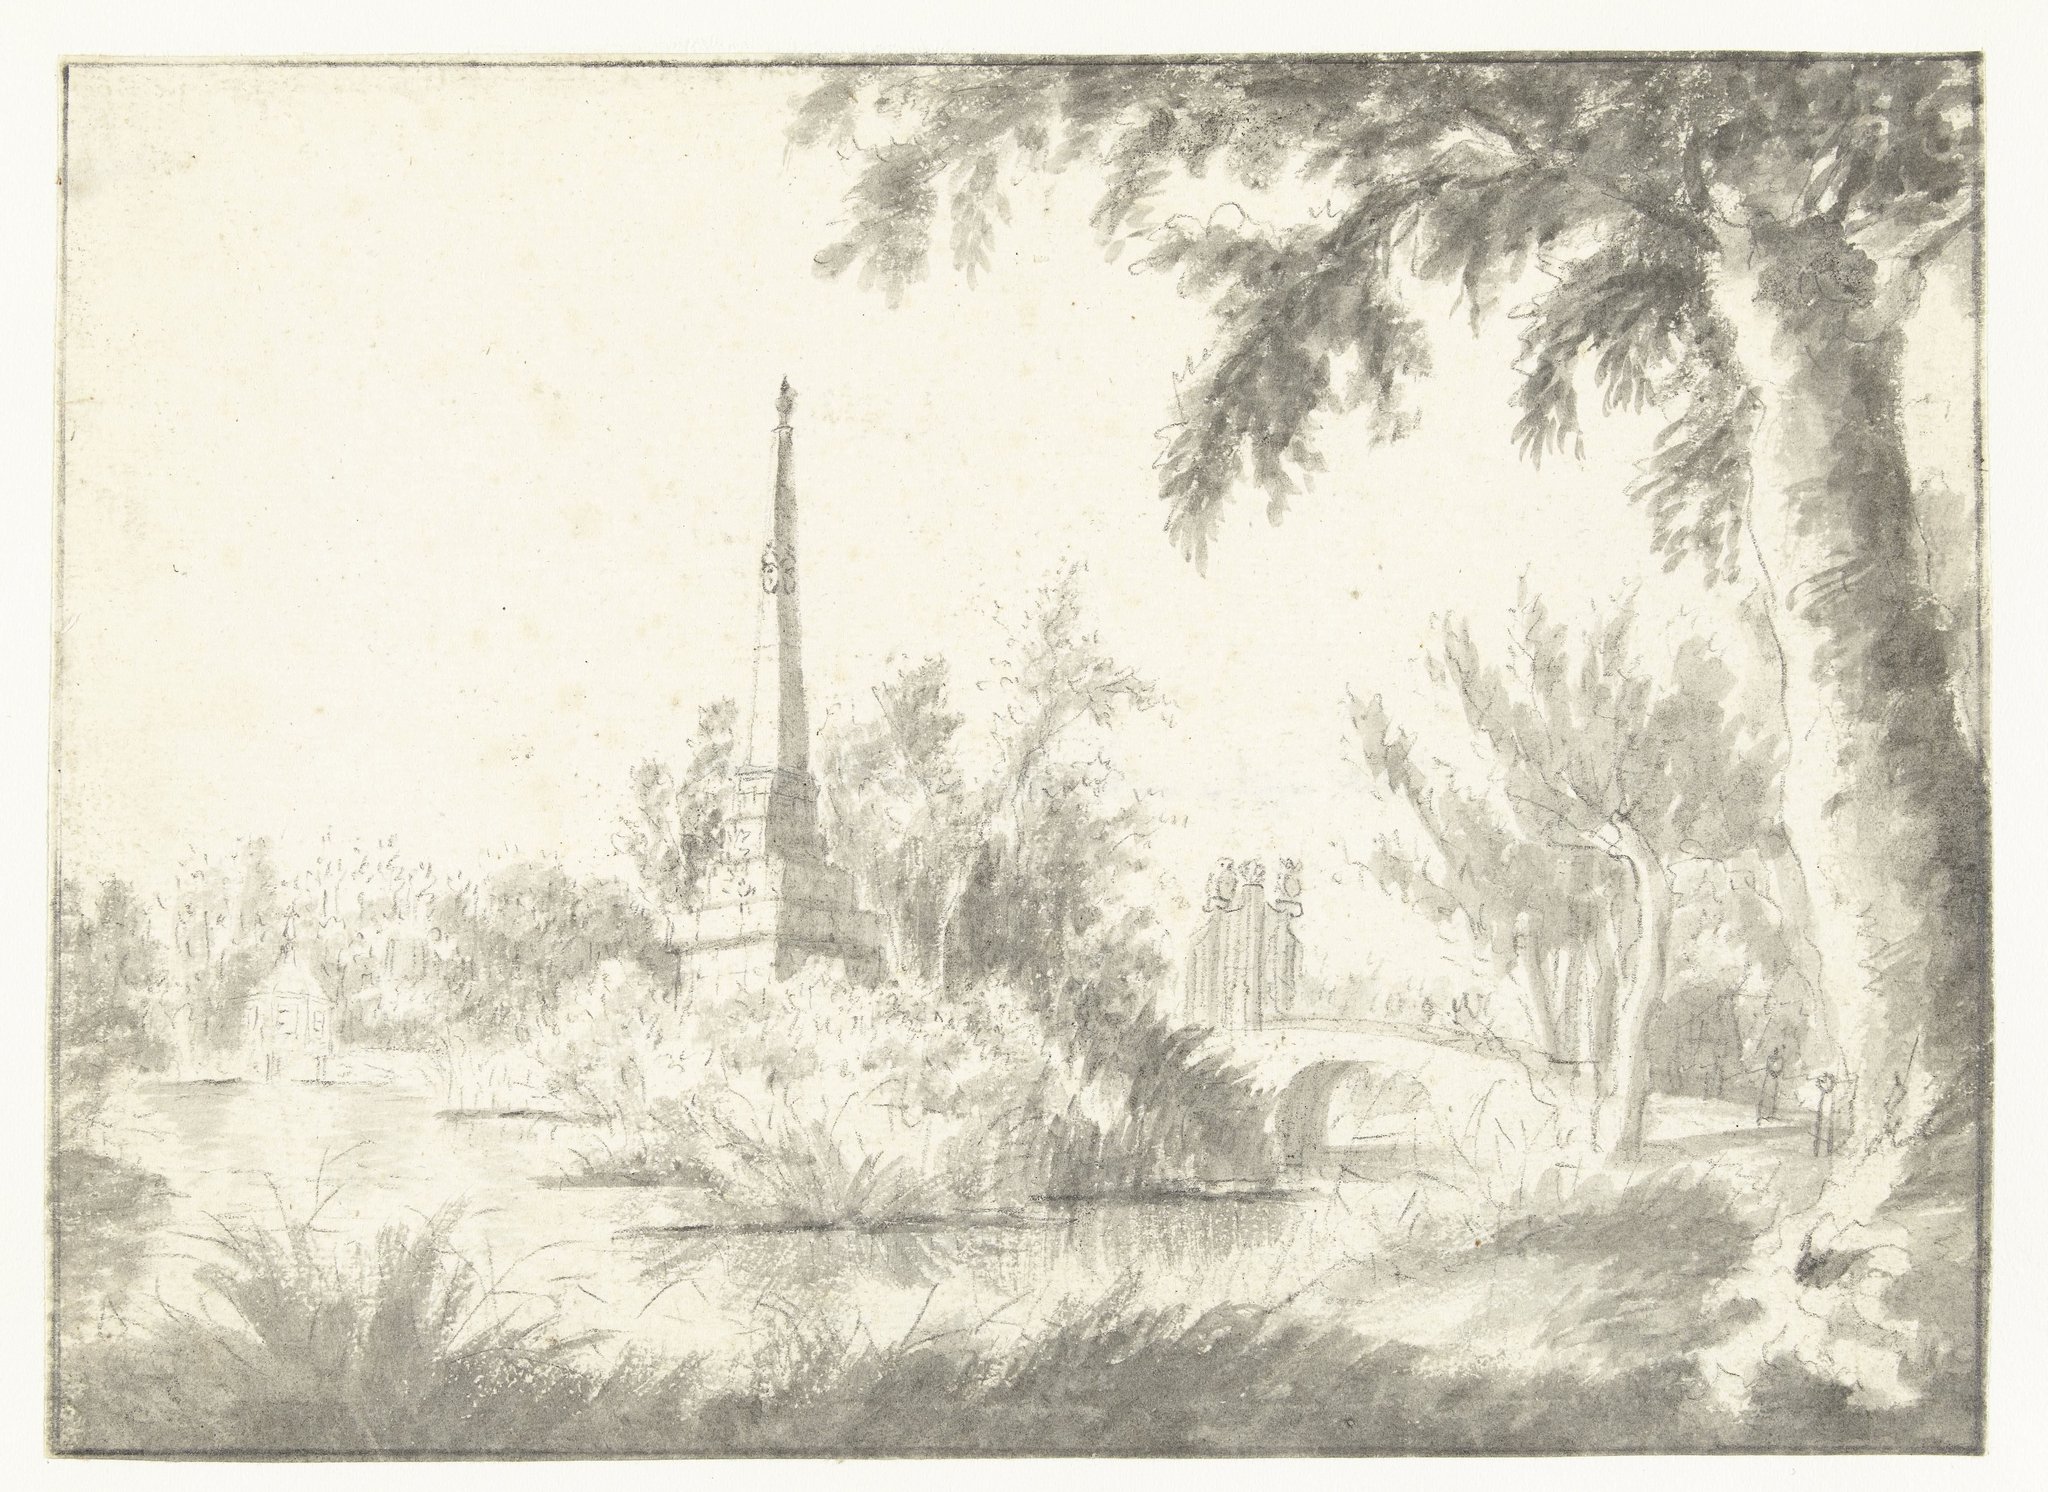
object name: drawing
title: De mijlpaal bij Amstelveen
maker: Anonymous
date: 1690-1700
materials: chalk, paper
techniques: brush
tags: landscape with monument, milestone